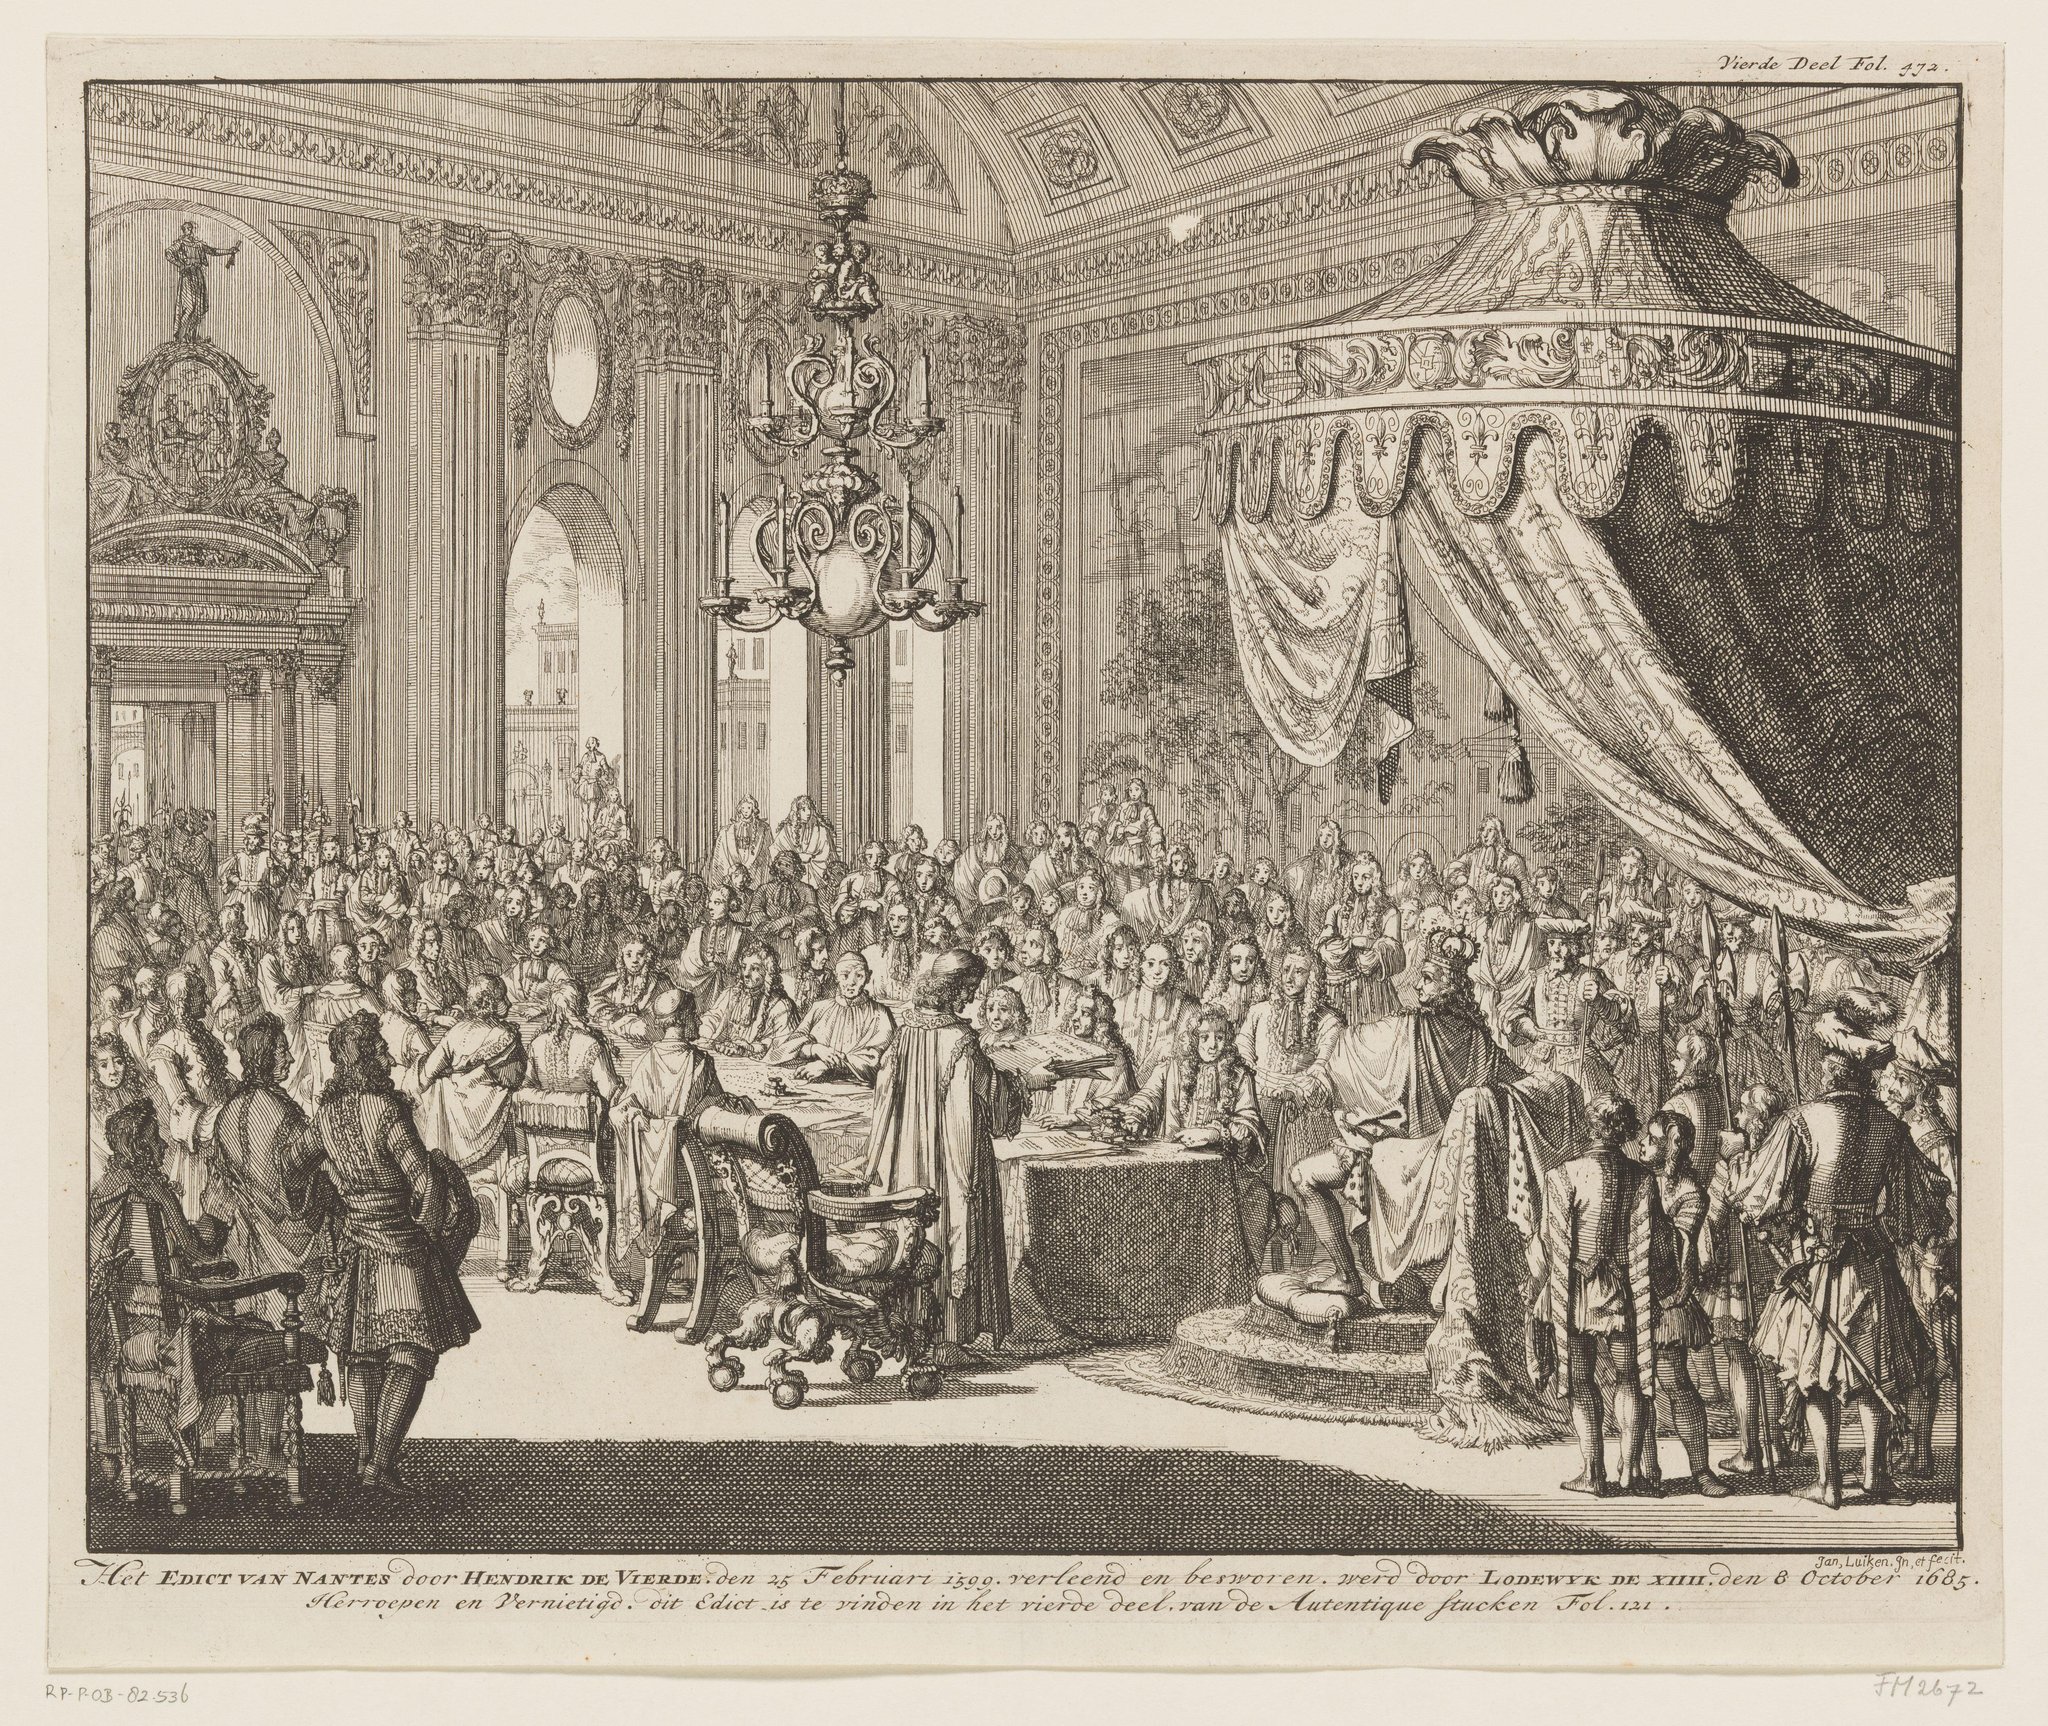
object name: history print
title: Herroeping van het Edict van Nantes, 1685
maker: jan luyken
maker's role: draughtsman, print maker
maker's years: 1649-1712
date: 1694-1696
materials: paper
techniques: etching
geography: northern netherlands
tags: lodewijk xiv (koning van frankrijk), meeting, assembly, france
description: De Herroeping van het Edict van Nantes, waarbij aan de protestanten in Frankrijk vrijheid van godsdienst was verleend, door de Franse koning Lodewijk XIV, 8 oktober 1685. Zaal waarin een grote groep personen bijeen is met de koning zittend rechts op zijn troon onder een baldakijn.